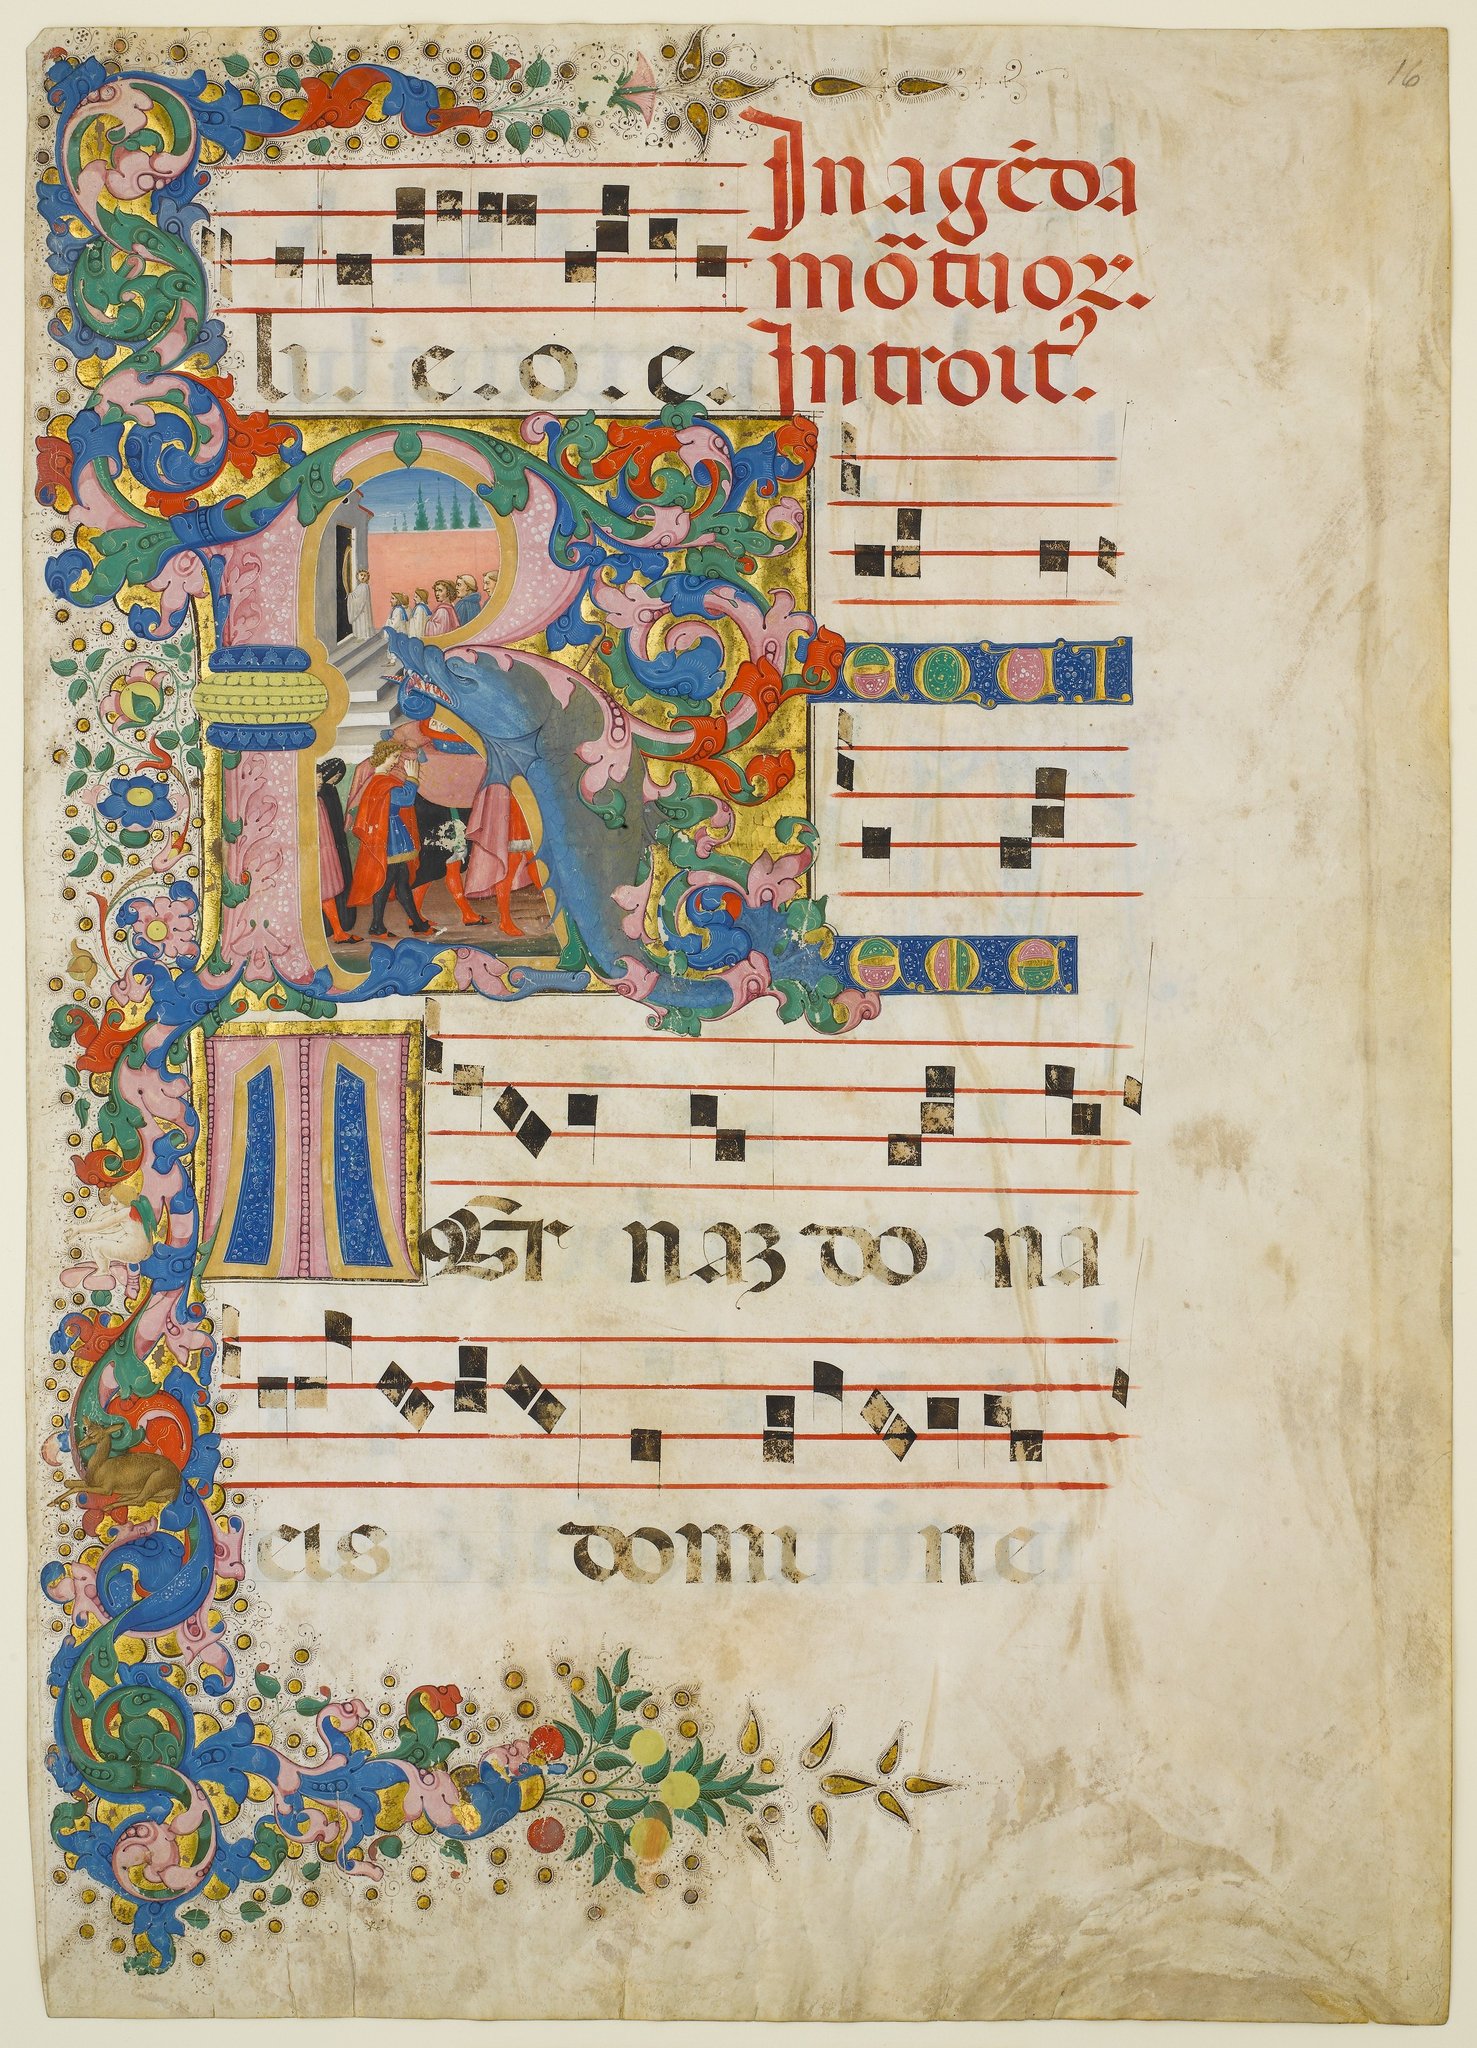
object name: gradual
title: Manuscript Leaf with a Funeral Procession in an Initial R, from a Gradual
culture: italian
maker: mariano del buono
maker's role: artist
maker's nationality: italian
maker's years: 1433-1504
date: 1451-1500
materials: gold, ink, parchment, paint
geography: italy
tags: processions